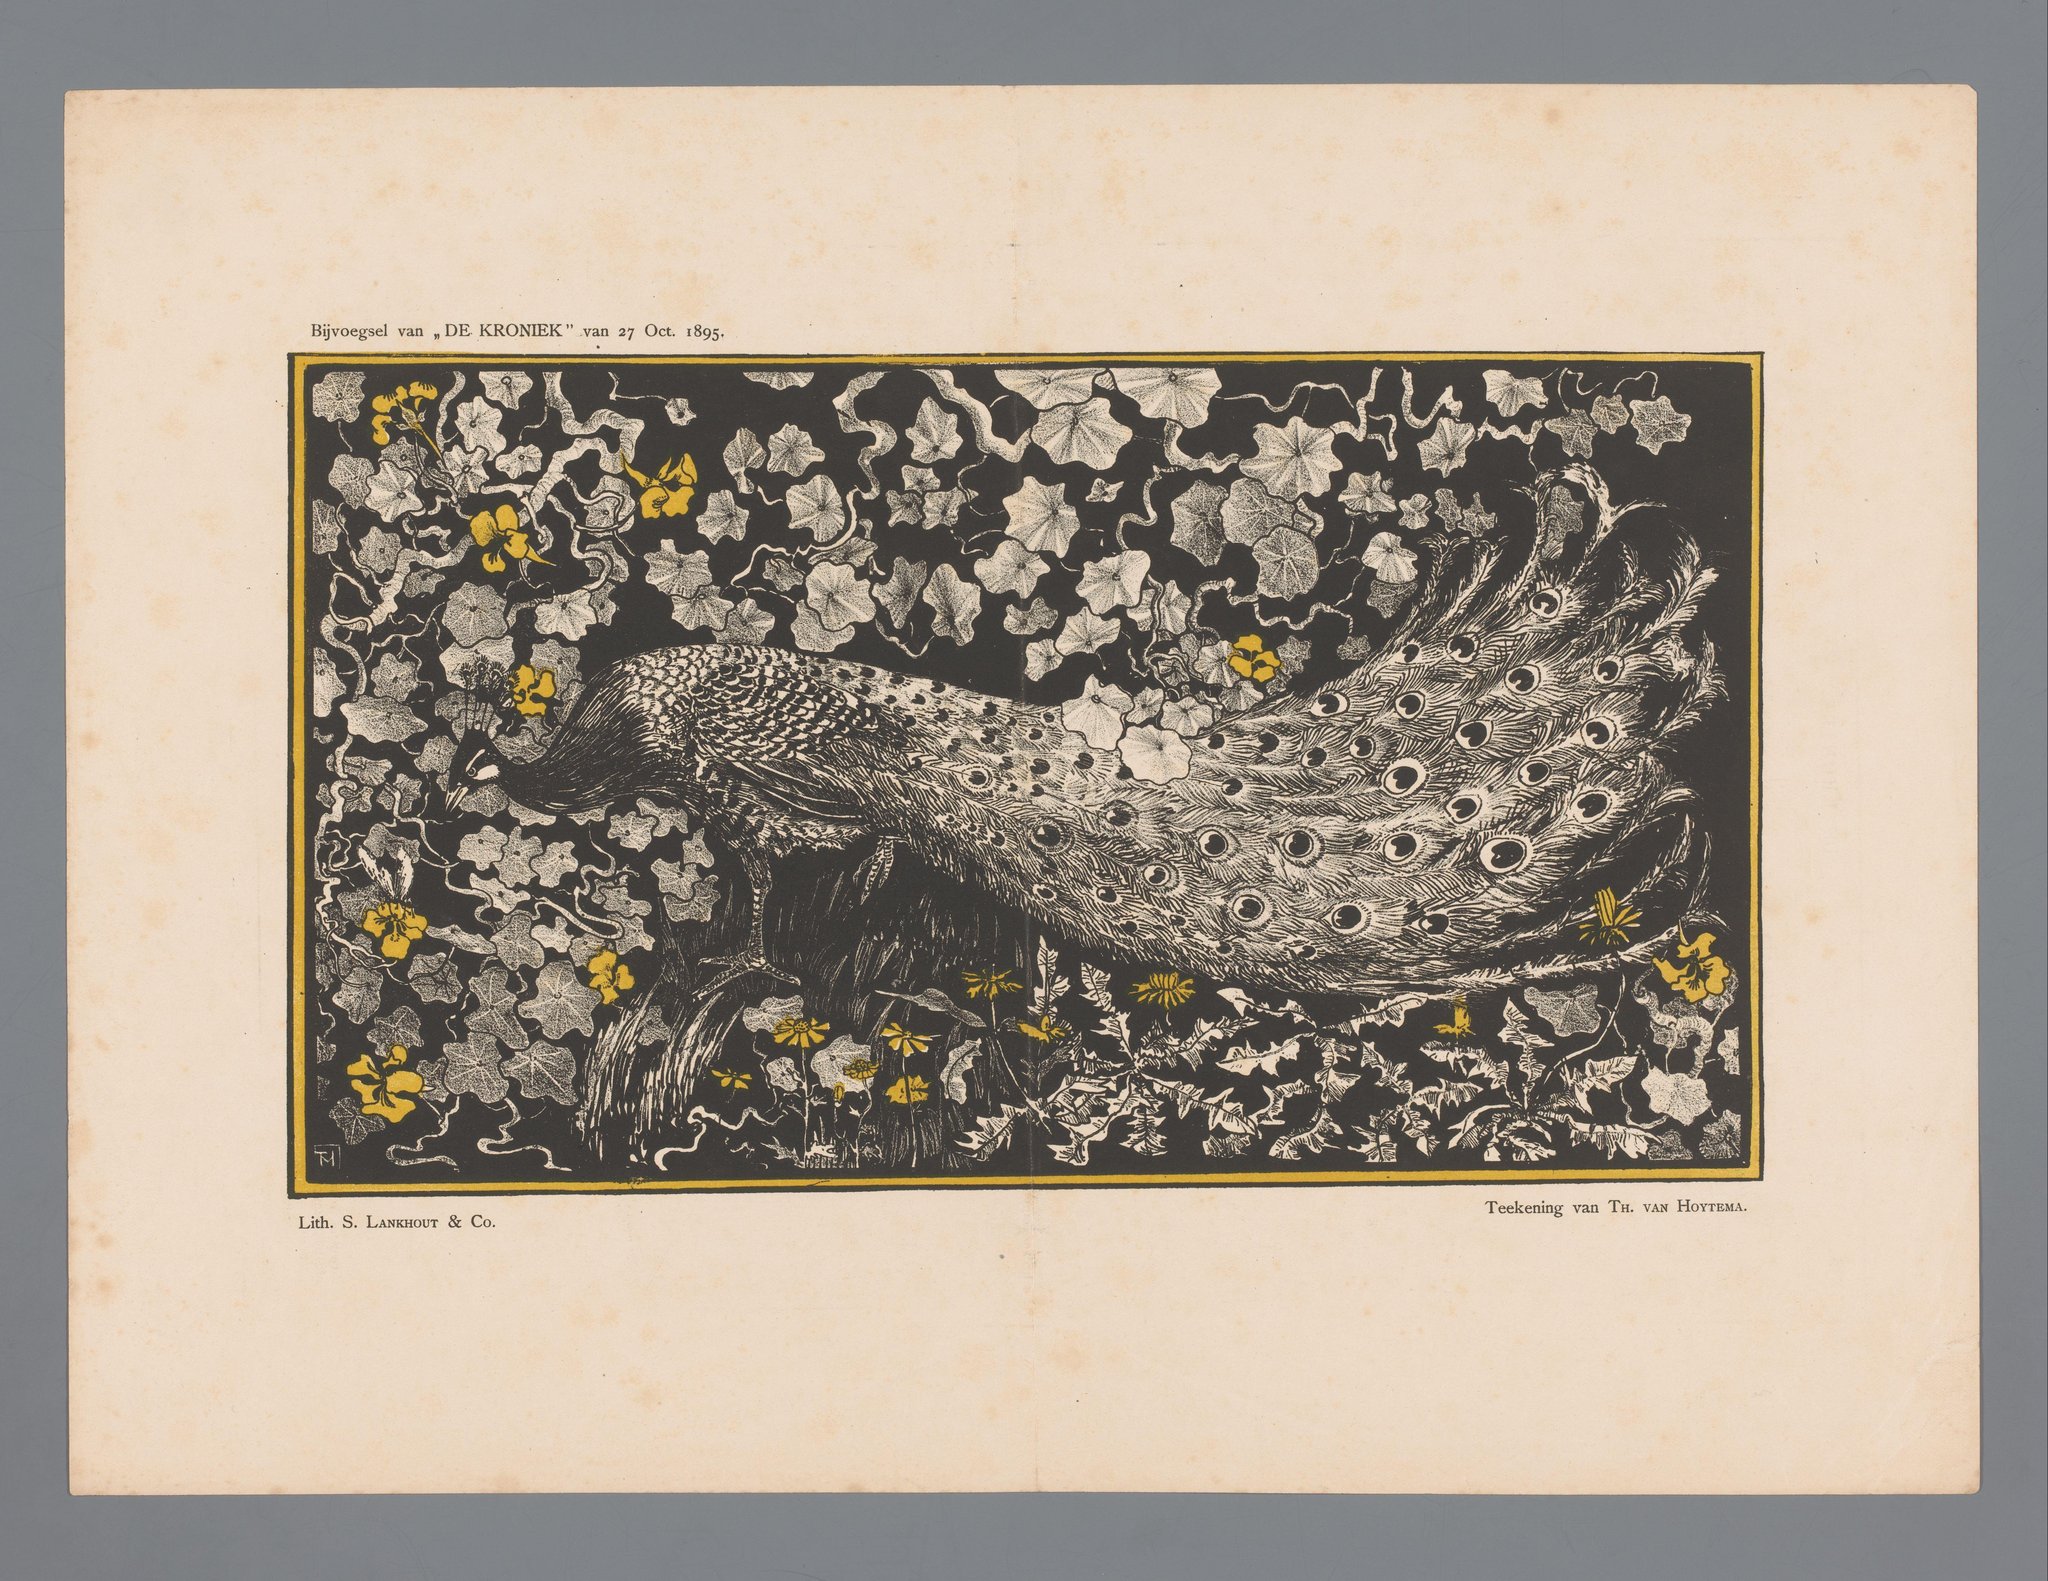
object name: print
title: Pauw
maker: theo van hoytema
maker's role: draughtsman, painter, print maker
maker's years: 1863-1917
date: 1895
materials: paper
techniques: lithograph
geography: the hague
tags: ornamental birds: peacock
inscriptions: date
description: Pauw, gepubliceerd als bijvoegsel bij 'De Kroniek'.